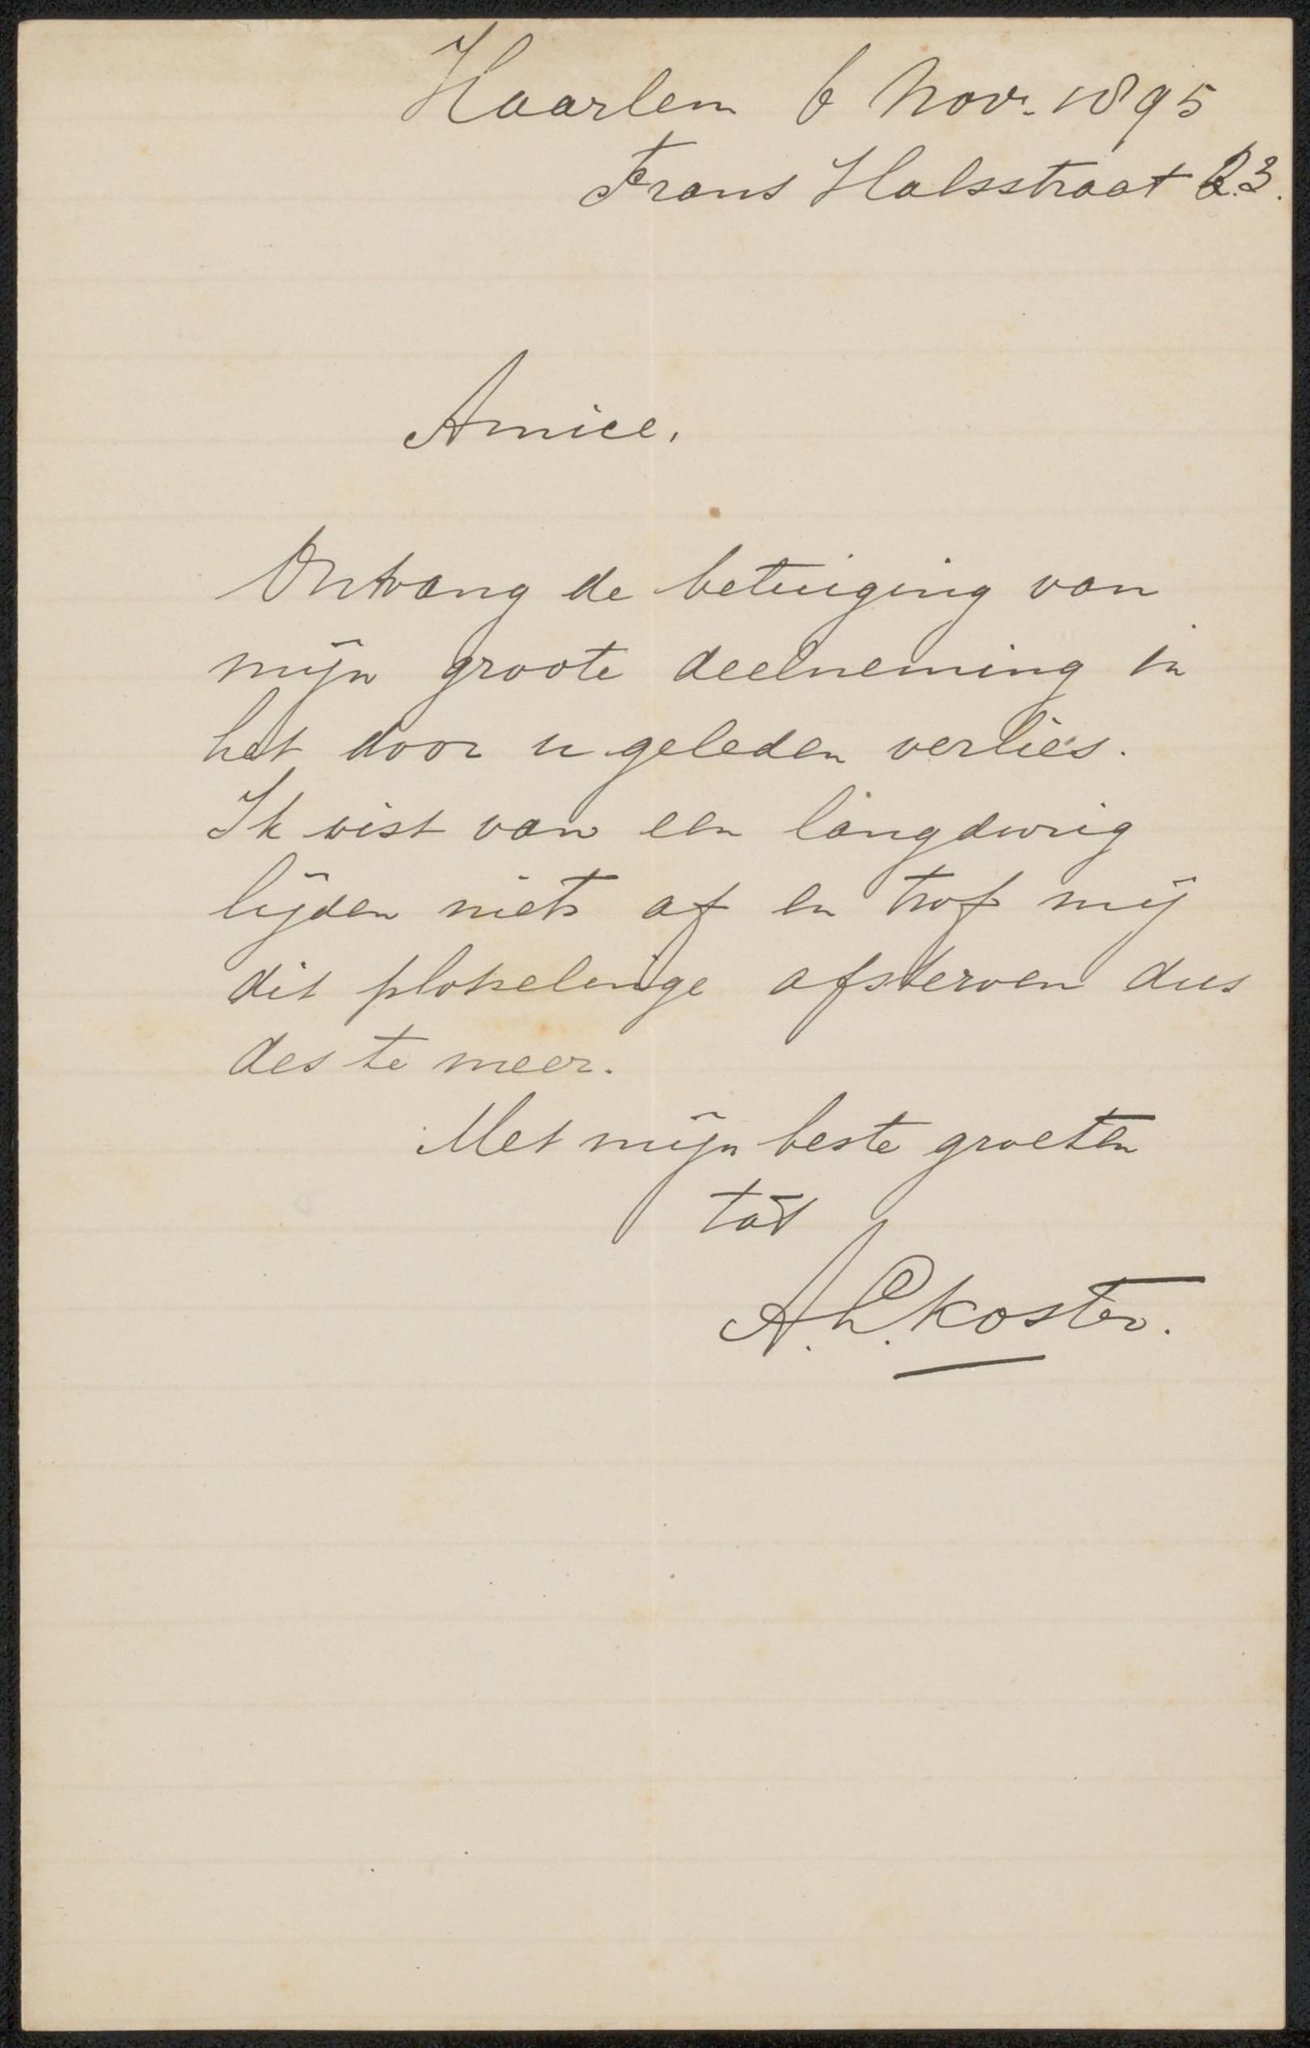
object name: letter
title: Brief aan Philip Zilcken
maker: anton l. koster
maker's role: draughtsman, painter, print maker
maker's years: 1859-1937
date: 1895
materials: ink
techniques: pen, writing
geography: haarlem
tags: brussels, helène lambertine hauzeur, the hague, painter, draughtsman, philip zilcken, passions, emotions, affections